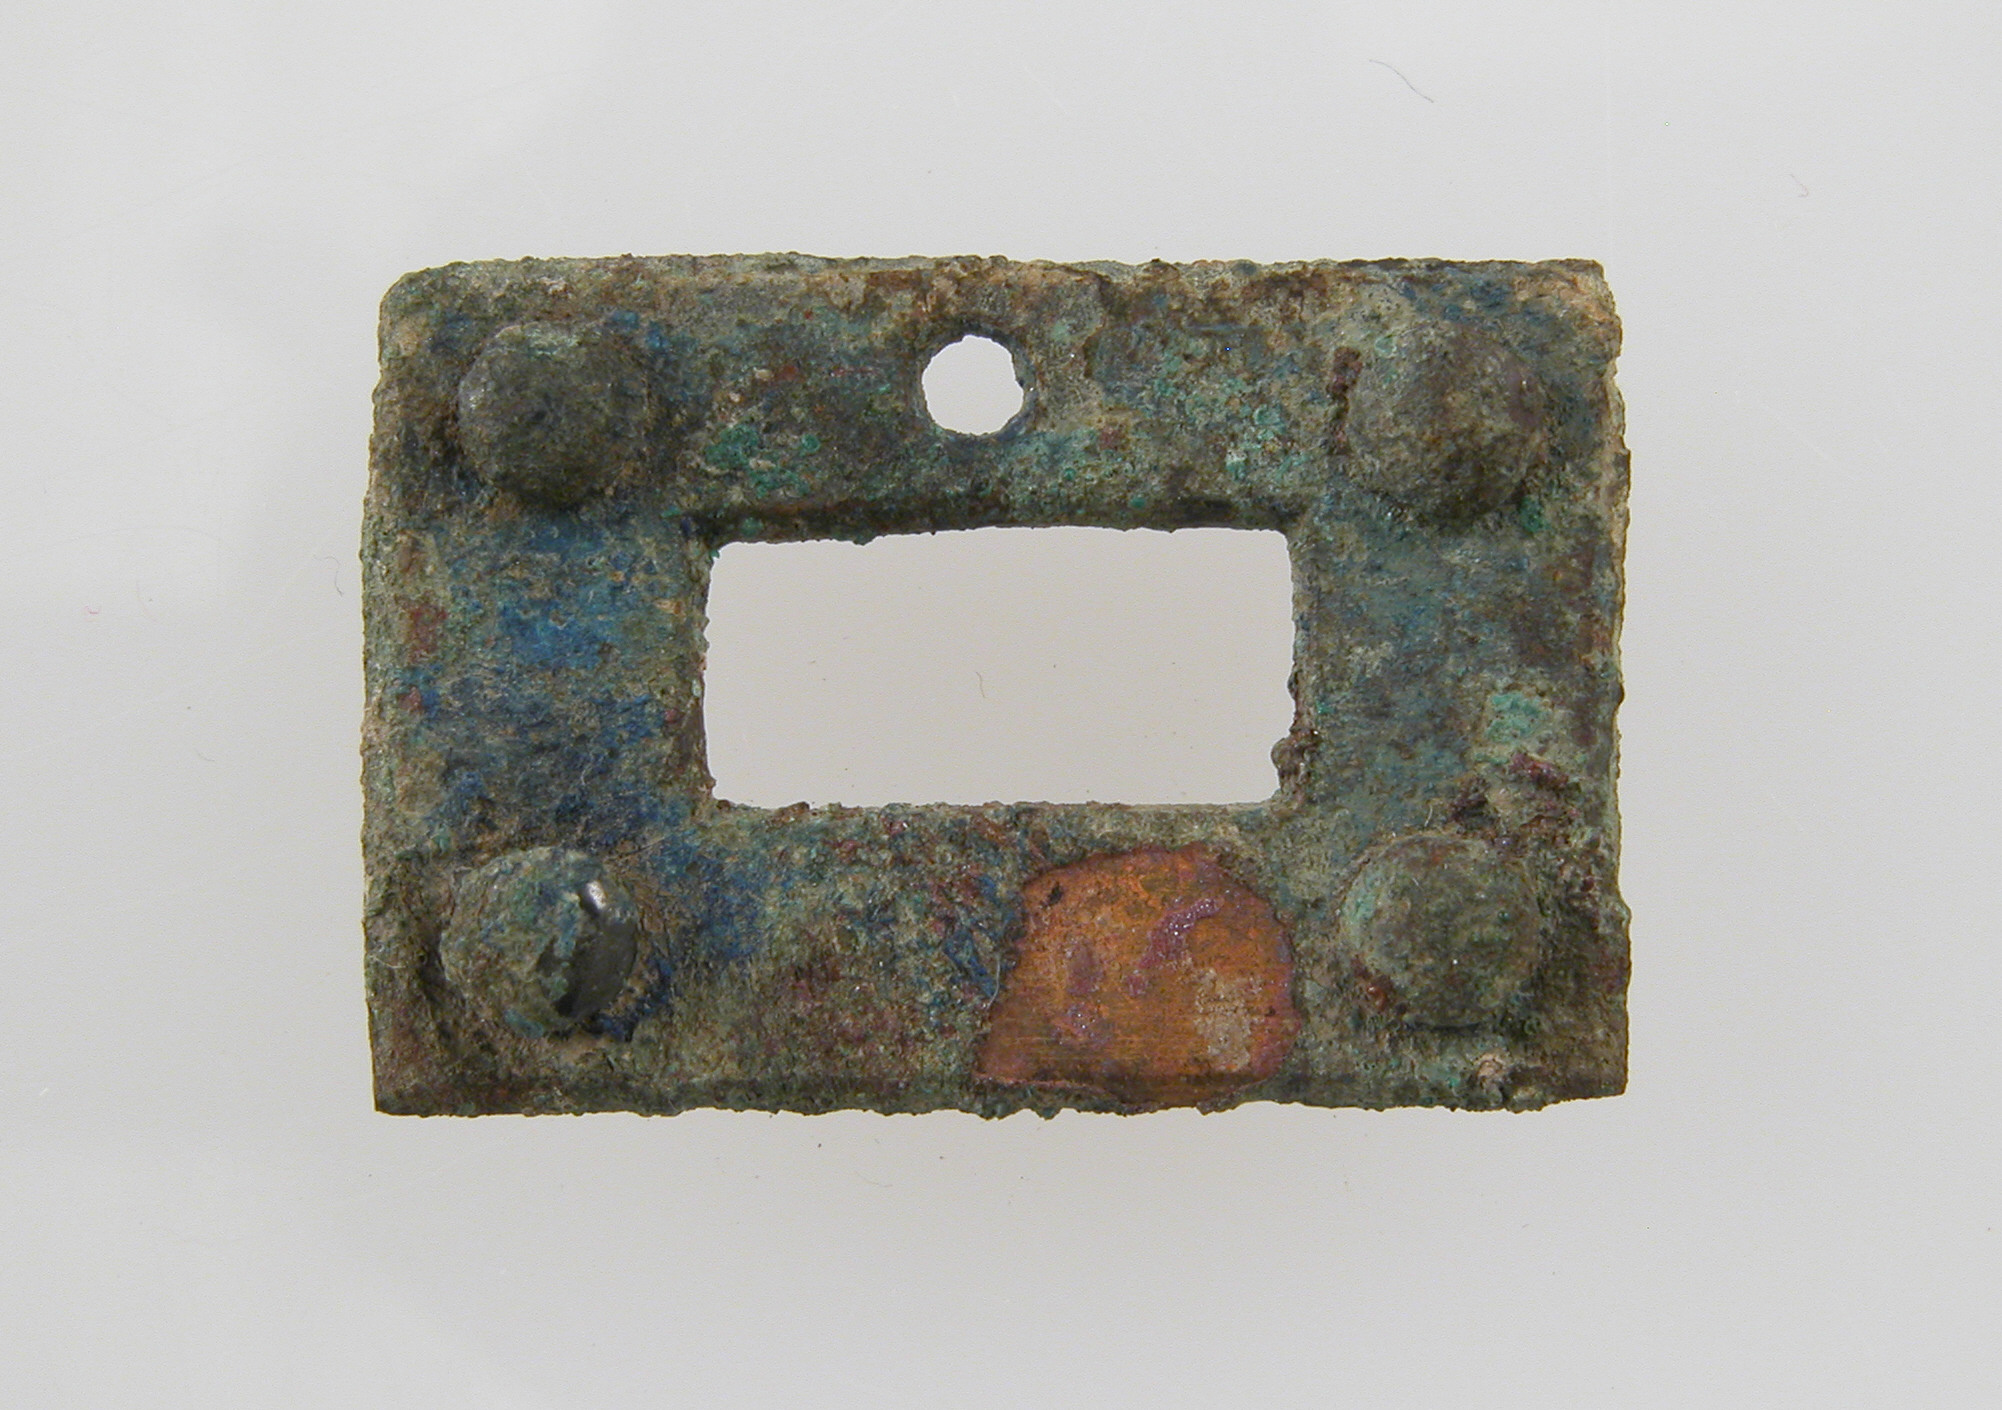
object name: plaque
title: Rectangular Plaque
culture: frankish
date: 534-566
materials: copper alloy